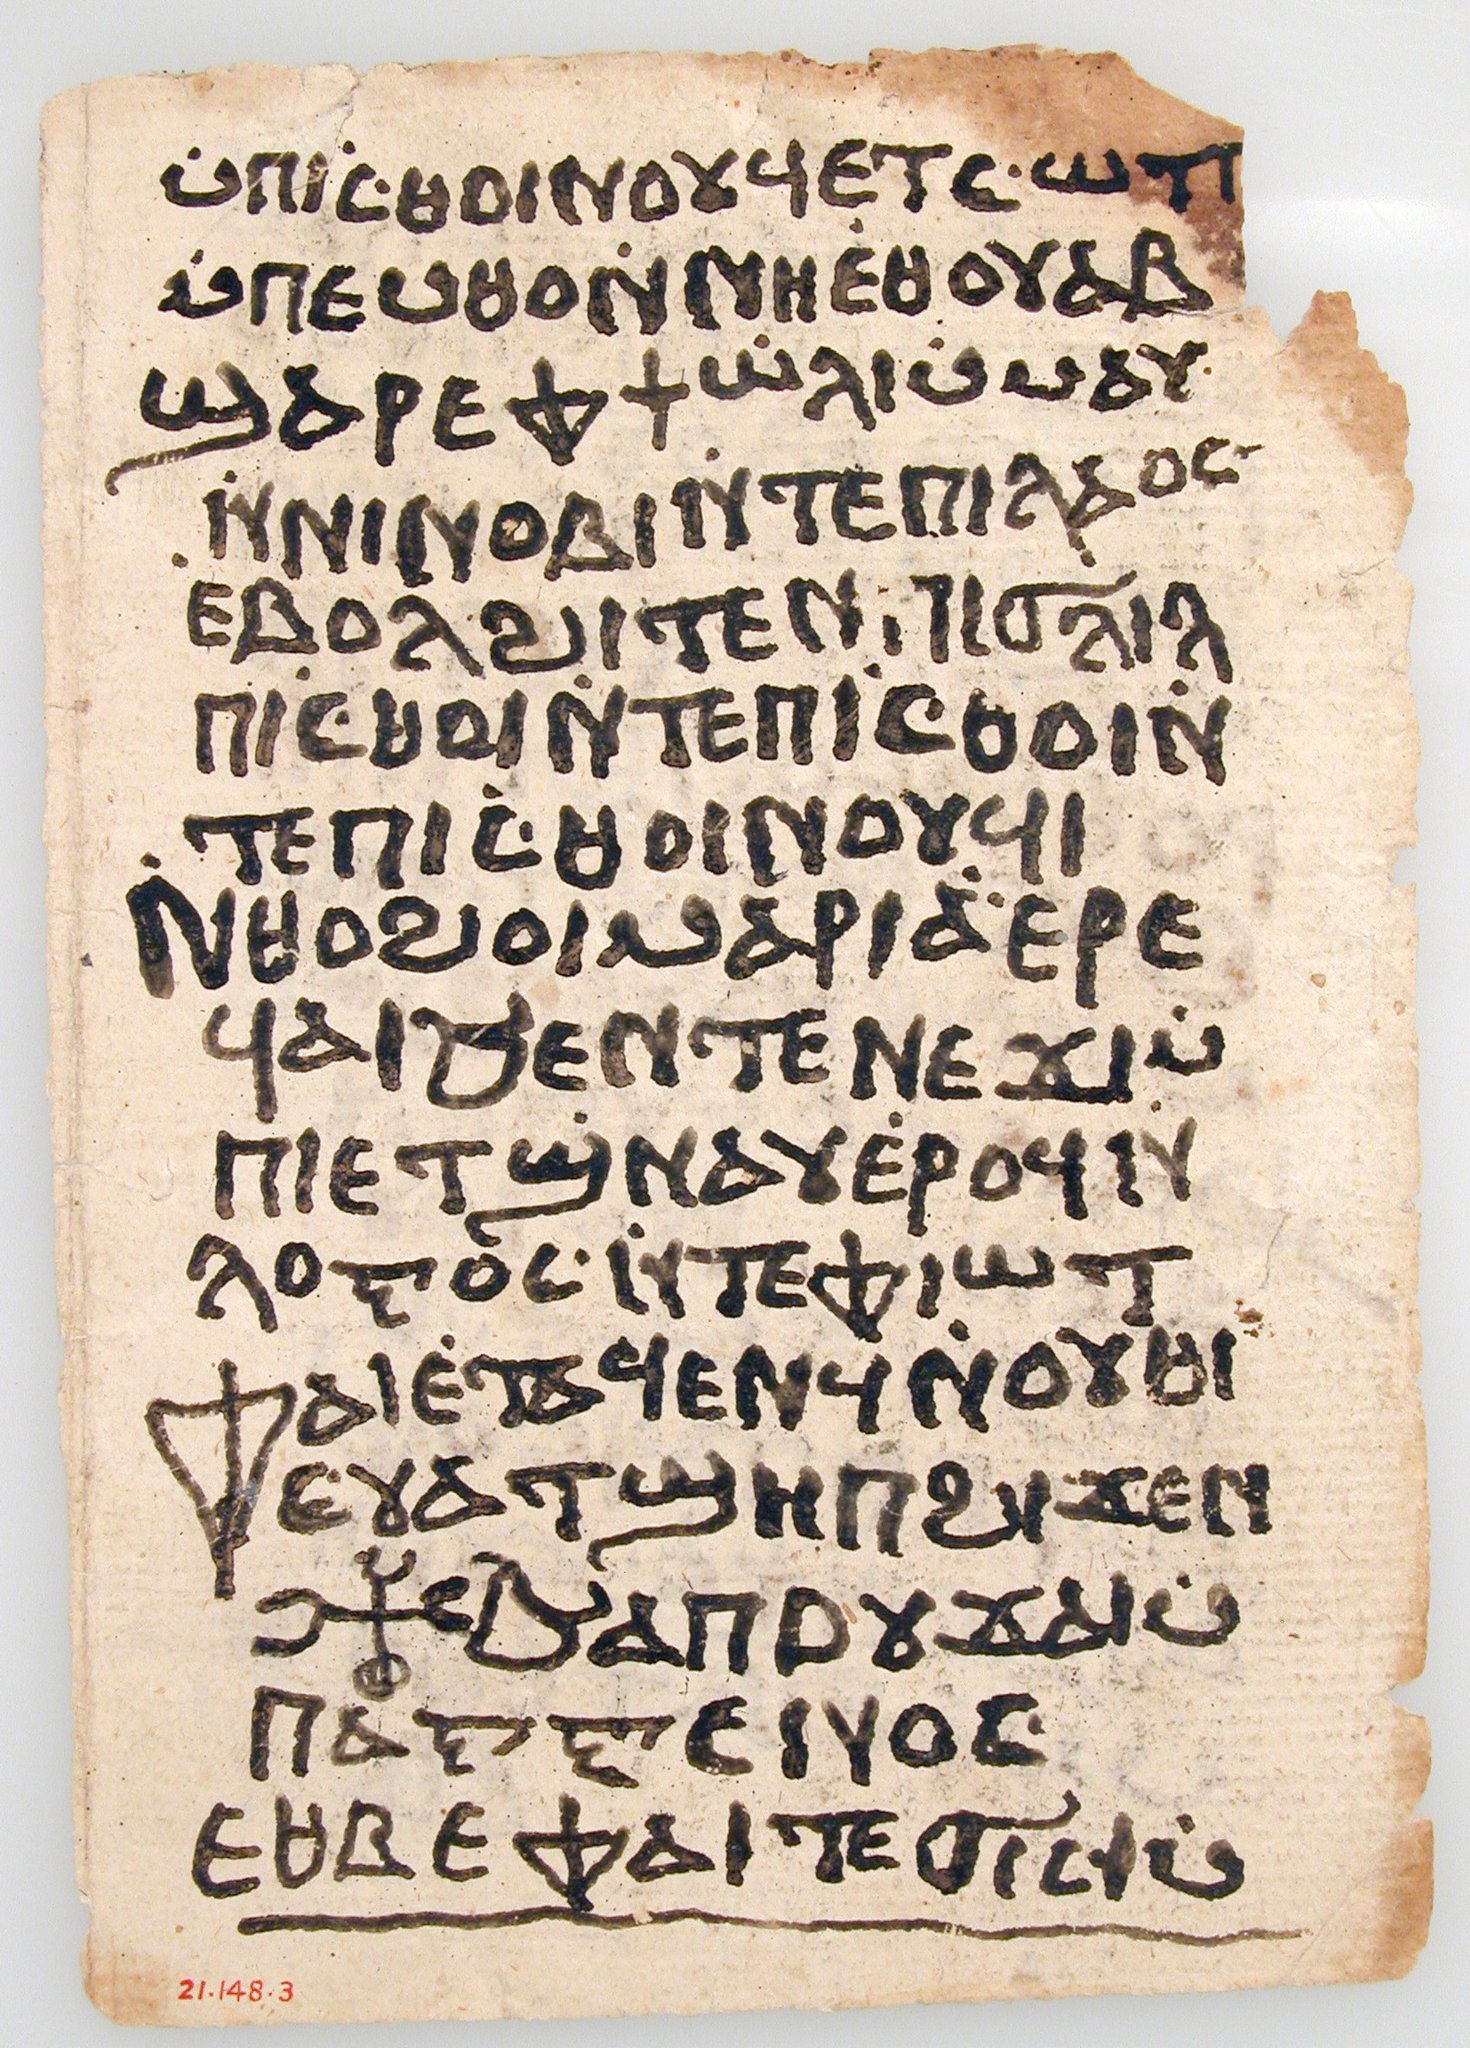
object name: manuscript leaf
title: Leaves from a Coptic Manuscript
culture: coptic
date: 501-1400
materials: ink, paper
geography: egypt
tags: coptic